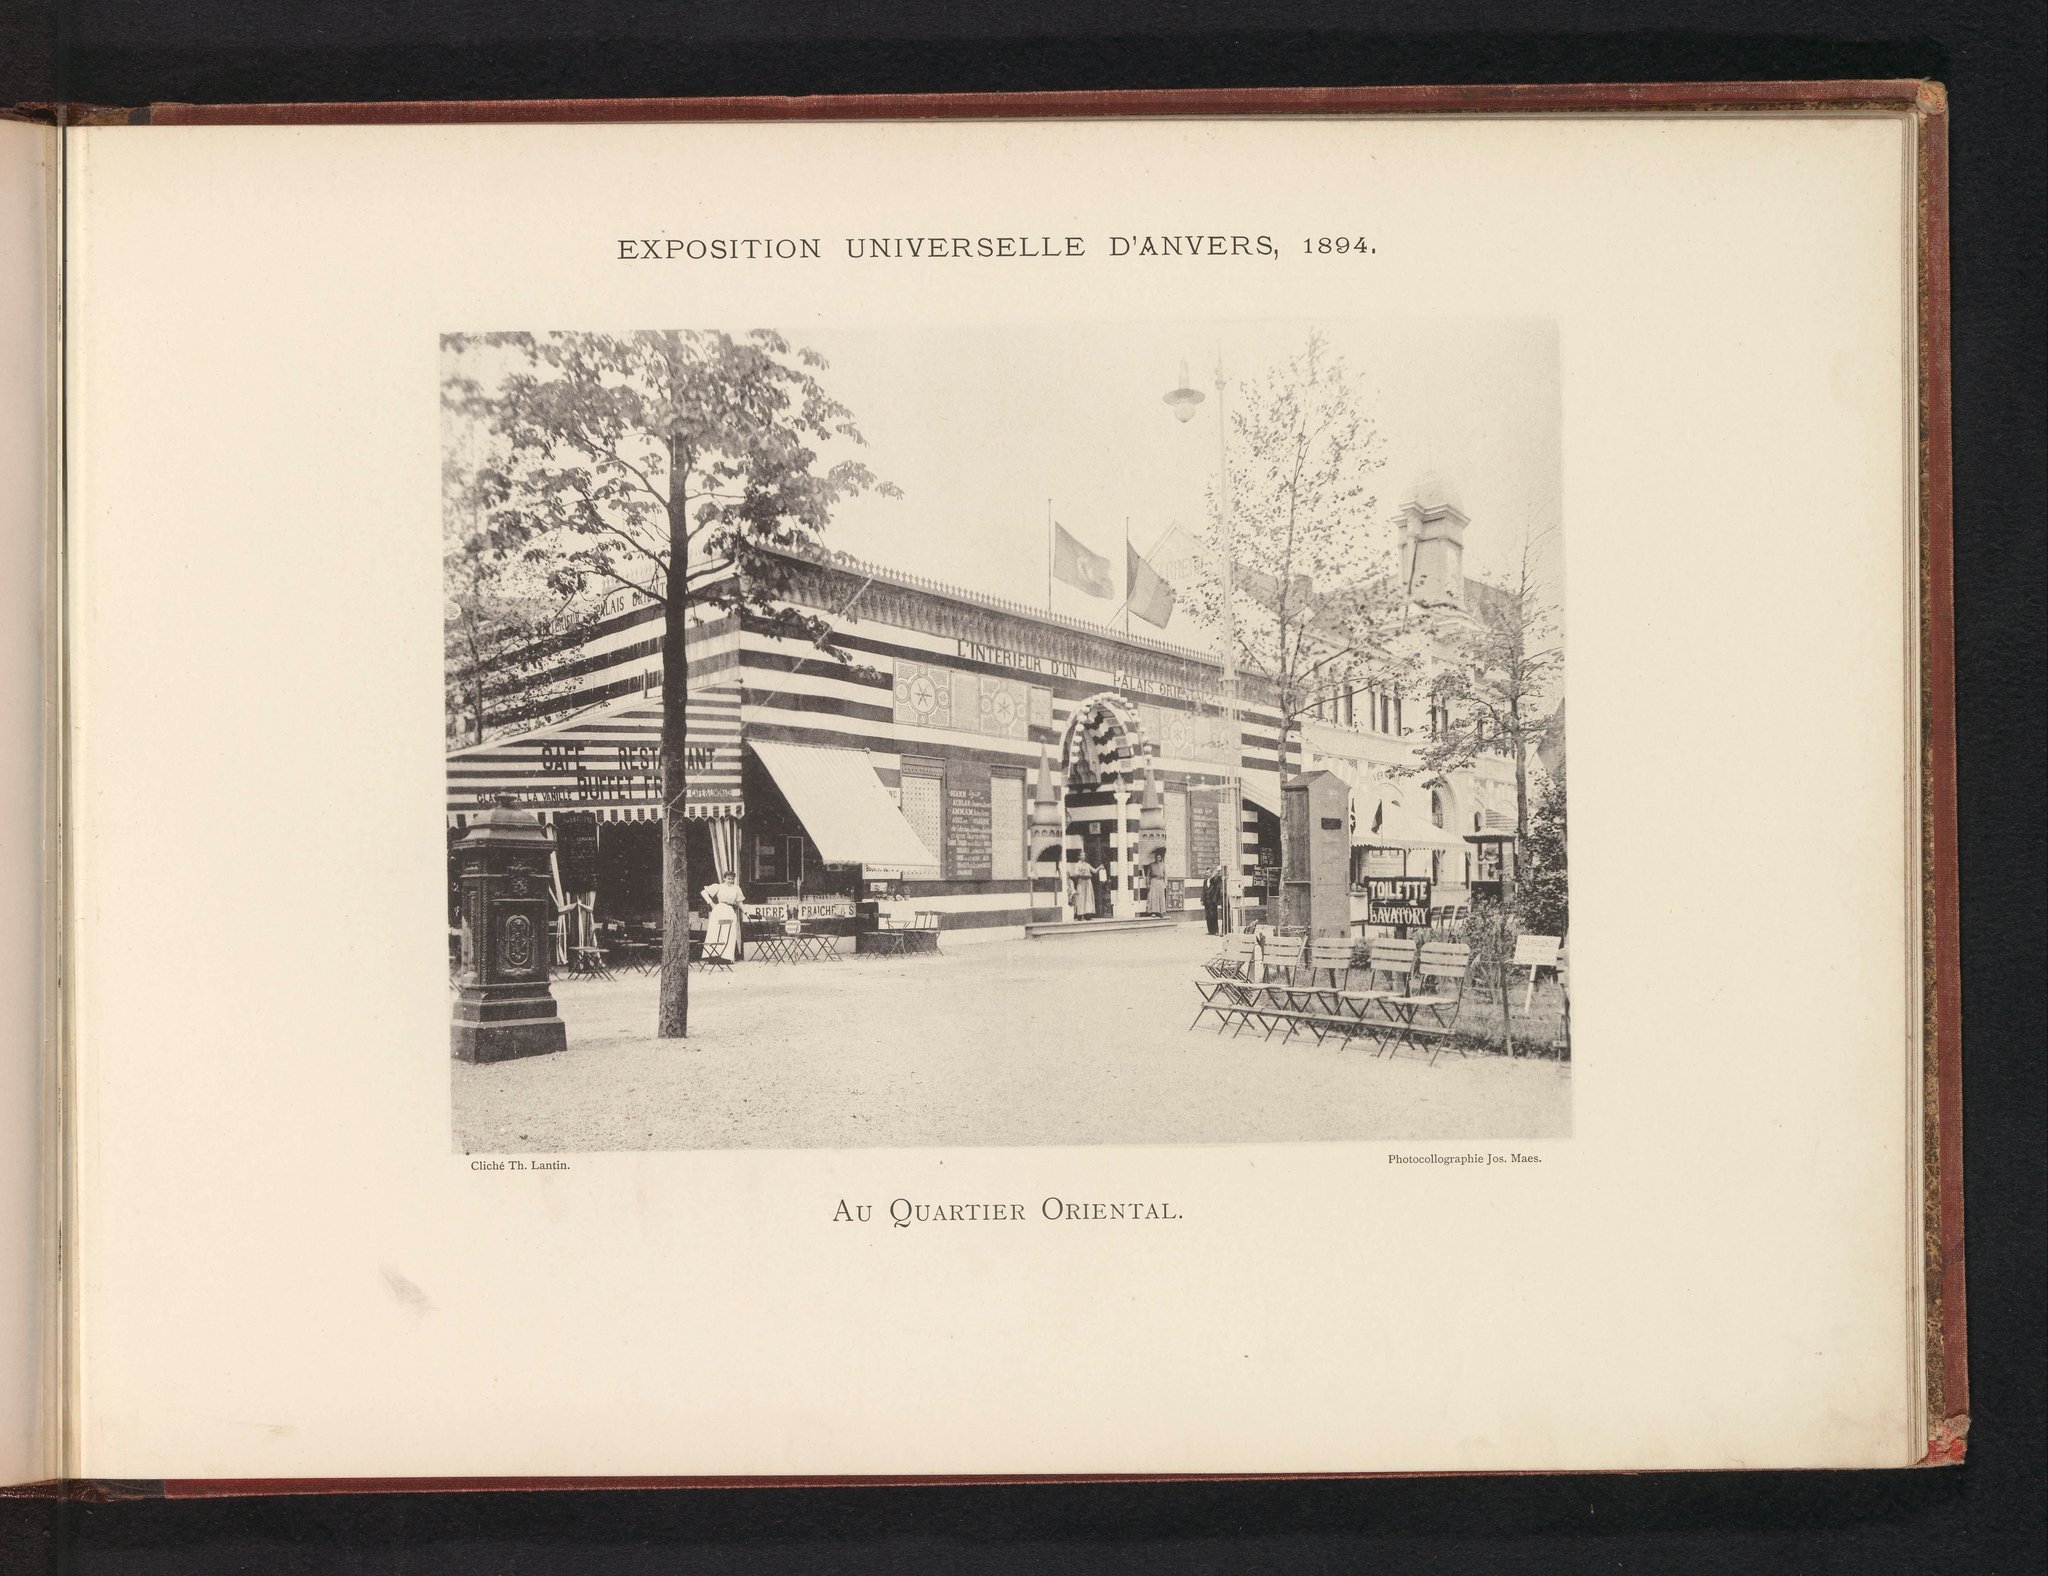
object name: photomechanical print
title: Exterieur van de Oriëntaalse sectie van de wereldtentoonstelling te Antwerpen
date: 1894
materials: paper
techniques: photograph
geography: antwerp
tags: world fair, world exhibition, façade (of house or building)